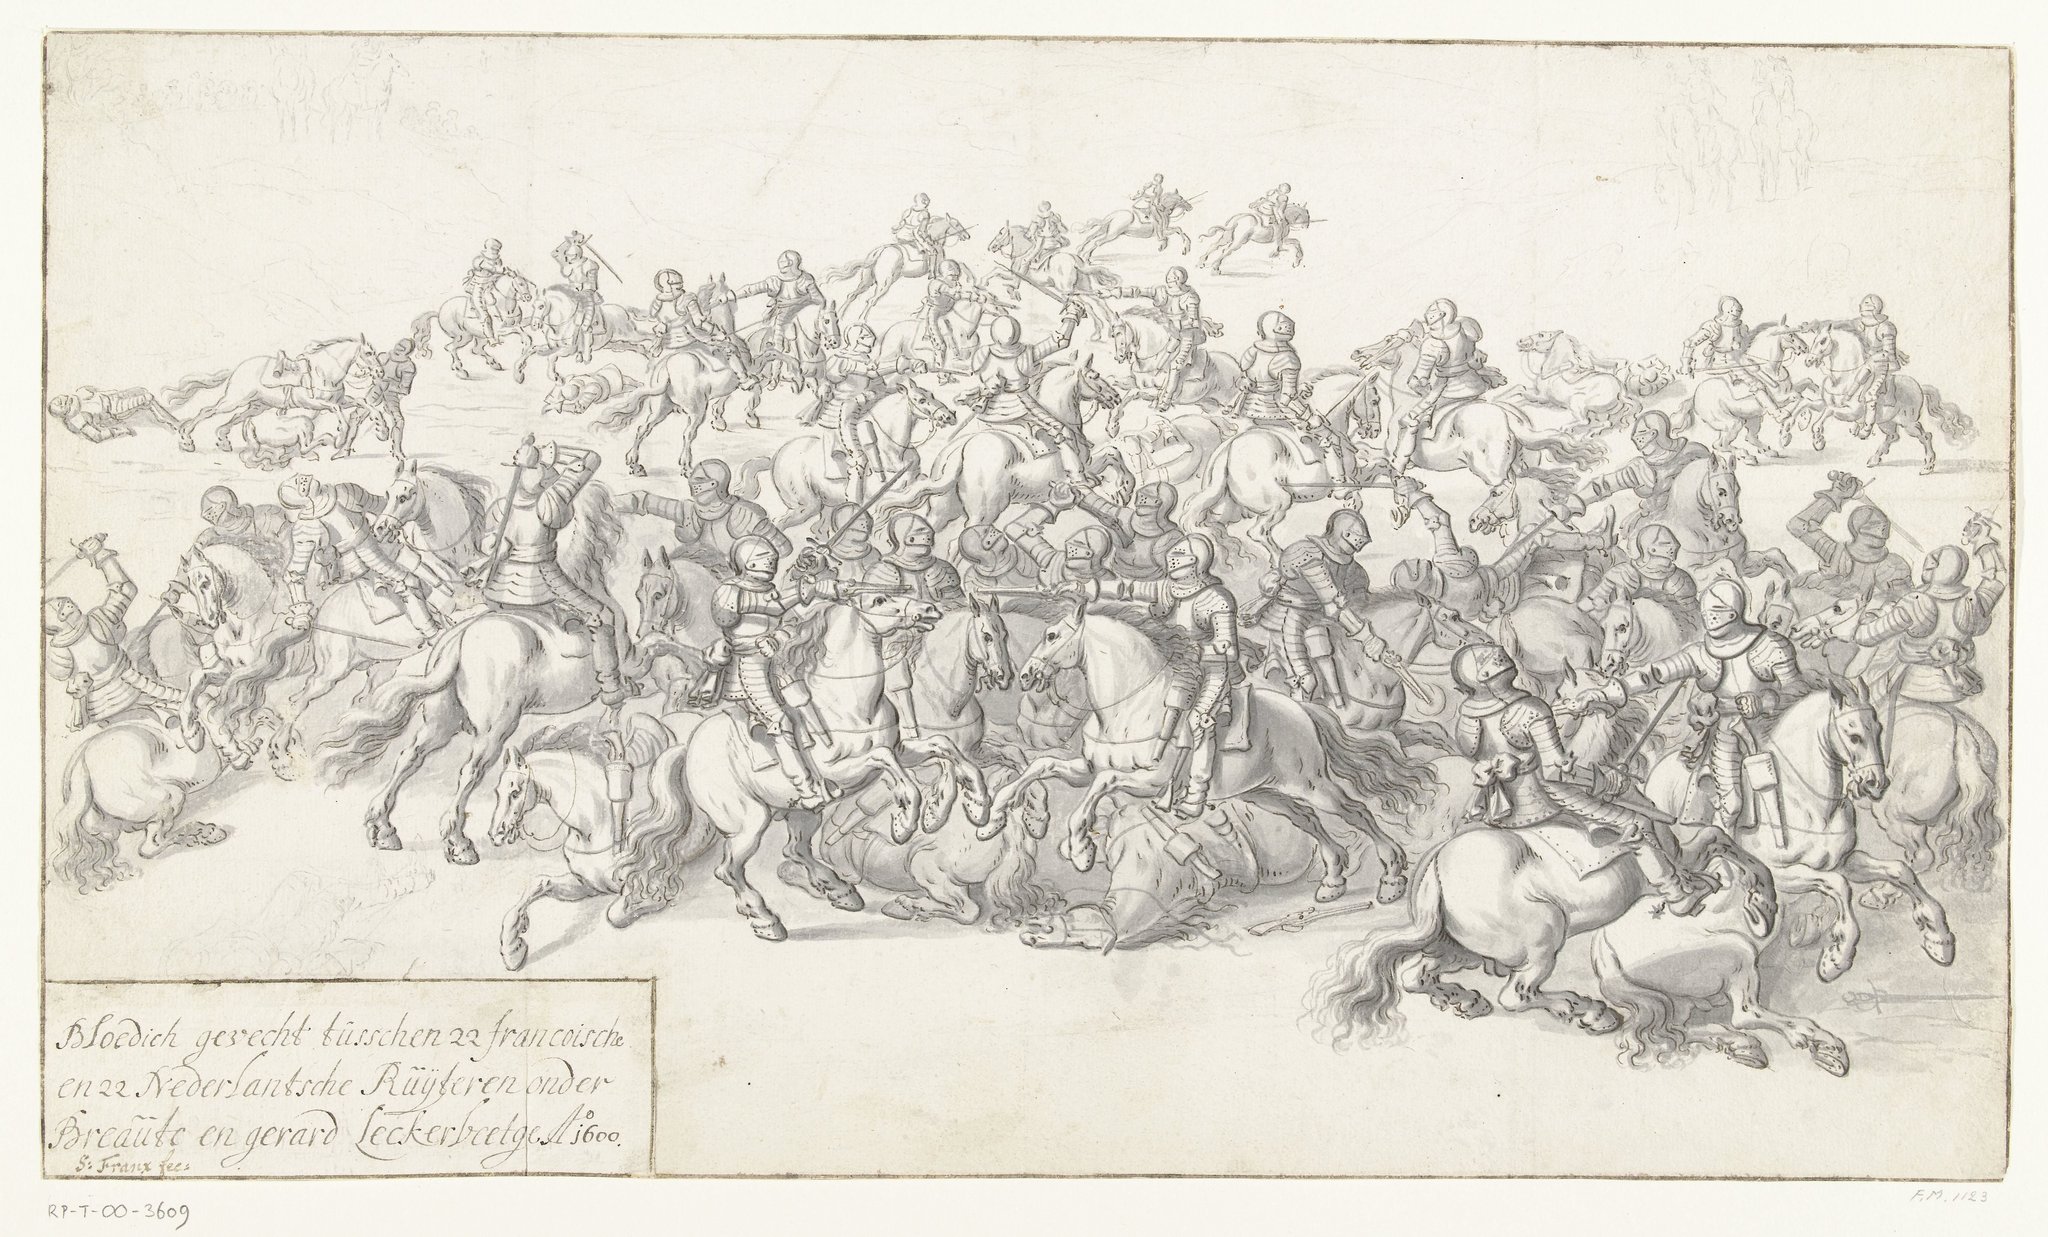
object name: drawing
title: Bloedich gevecht tusschen 22 francoische en 22 Nederlantsche Ruyteren onder Breaut en gerard Leckerbeetge Ao. 1600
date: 1600-1699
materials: paper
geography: low countries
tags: den bosch, battle (+ land forces)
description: Het gevecht van Lekkerbeetje. Ruitergevecht op de Vughterheide bij Den Bosch tussen de Spaanse ruiters onder Anthony Schetz van Grobbendonck en de Staatse ruiters onder de Pierre de Breauté, 5 februari 1600. Het lijk van Lekkerbeetje alleen schetsmatig weergegeven. Linksonder een ingezet stuk papier waarop de titel.